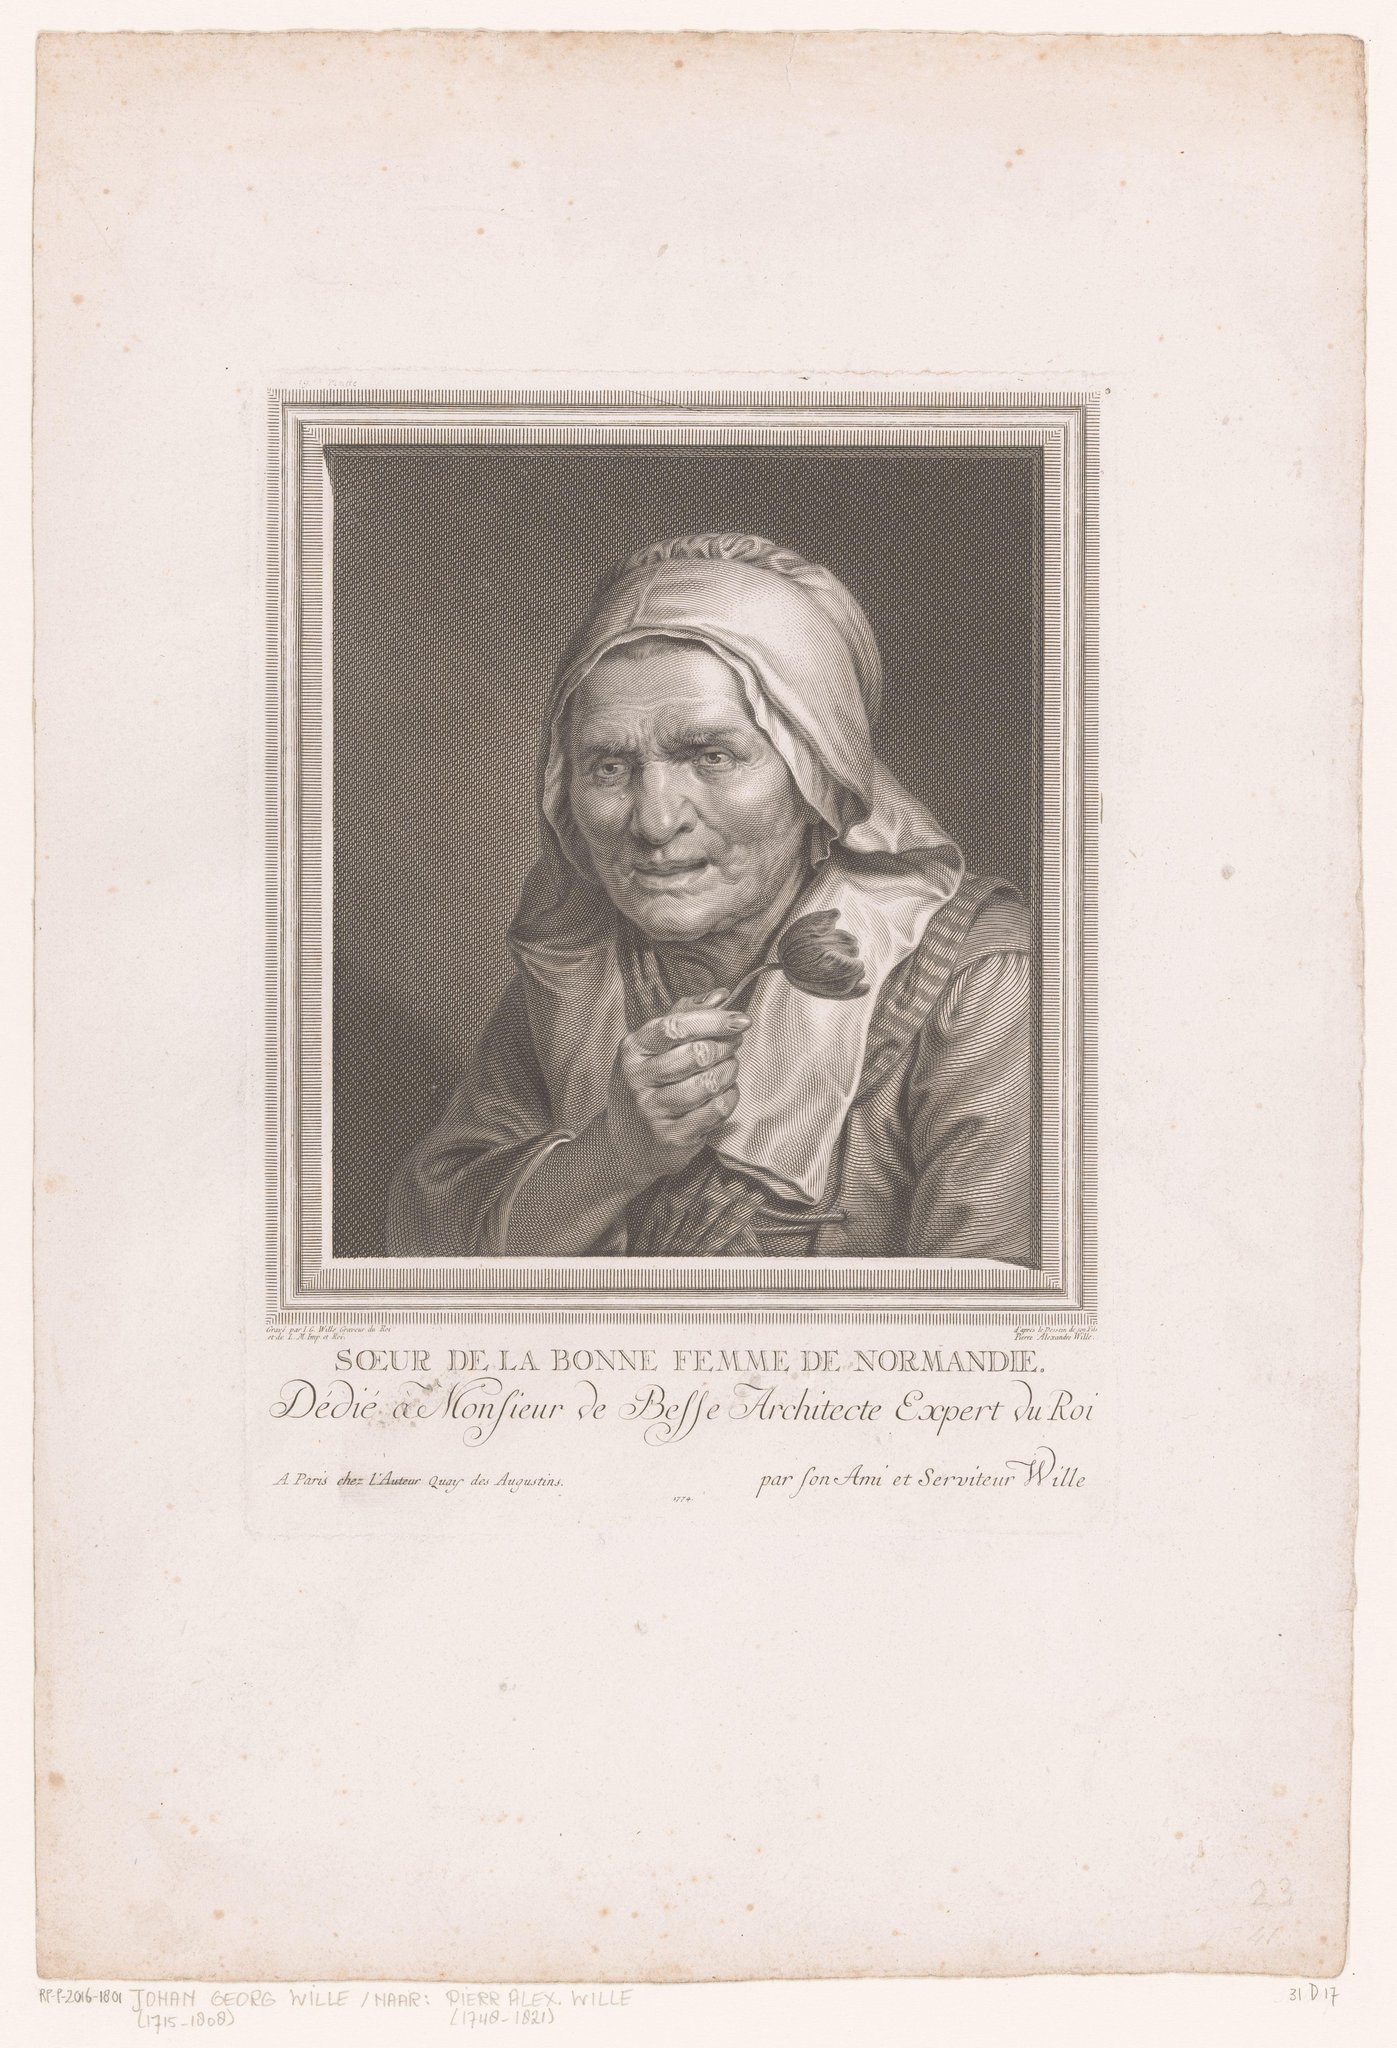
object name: print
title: Oude vrouw met tulp in de hand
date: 1774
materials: paper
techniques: engraving, etching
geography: paris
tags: old woman, head-gear: cap, flowers: tulip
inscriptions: collector's mark: Lugt 2228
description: Deze prent maakt deel uit van een serie van onbekende omvang naar Nederlandse en Duitse schilderijen. Op sommige prenten staat linksboven aangegeven welk nummer in de serie het betreft.